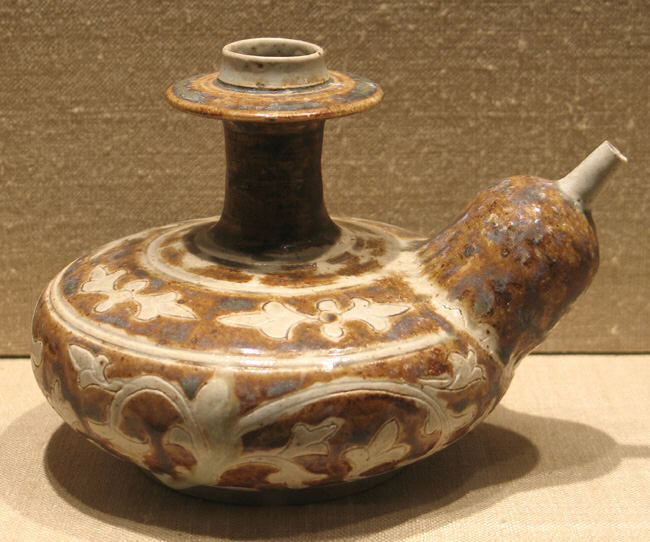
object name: kendi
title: Kendi (Drinking Vessel)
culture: thai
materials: earthenware, glaze, iron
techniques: underglaze